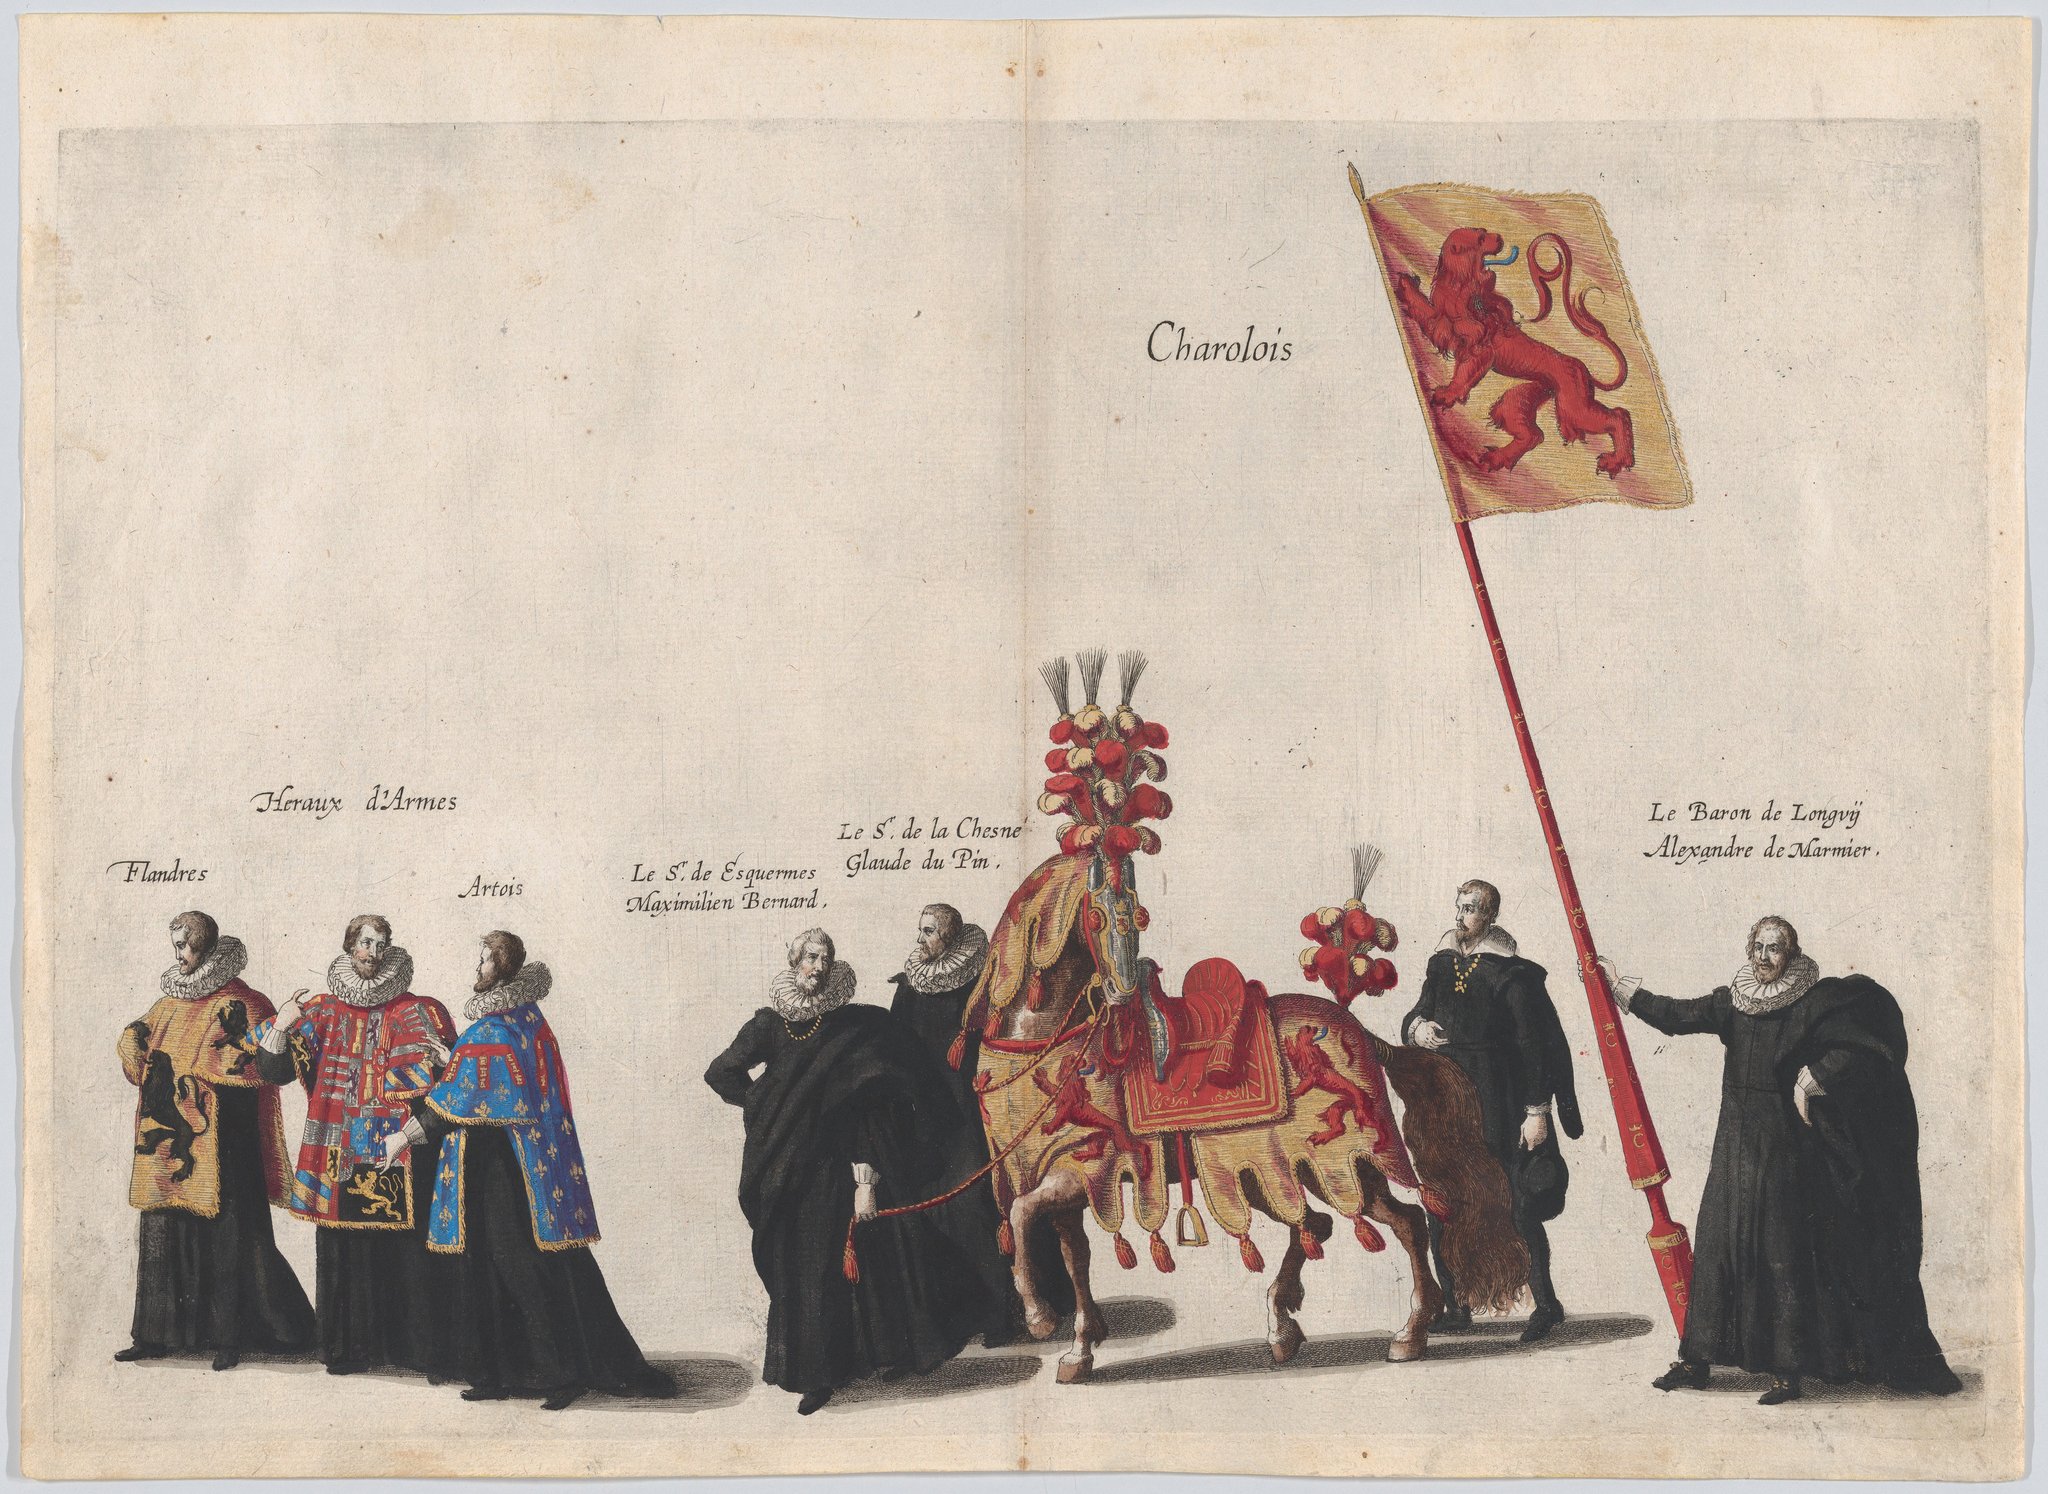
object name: print, fete, ornament architecture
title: Plate 35: Men with heraldic flags and horses from Charolois marching in the funeral procession of Archduke Albert of Austria; from 'Pompa Funebris ... Alberti Pii'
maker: cornelis galle (i)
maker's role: artist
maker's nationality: netherlandish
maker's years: 1576-1650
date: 1623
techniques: etching, hand coloring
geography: brussels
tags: men,horses,lions,flags